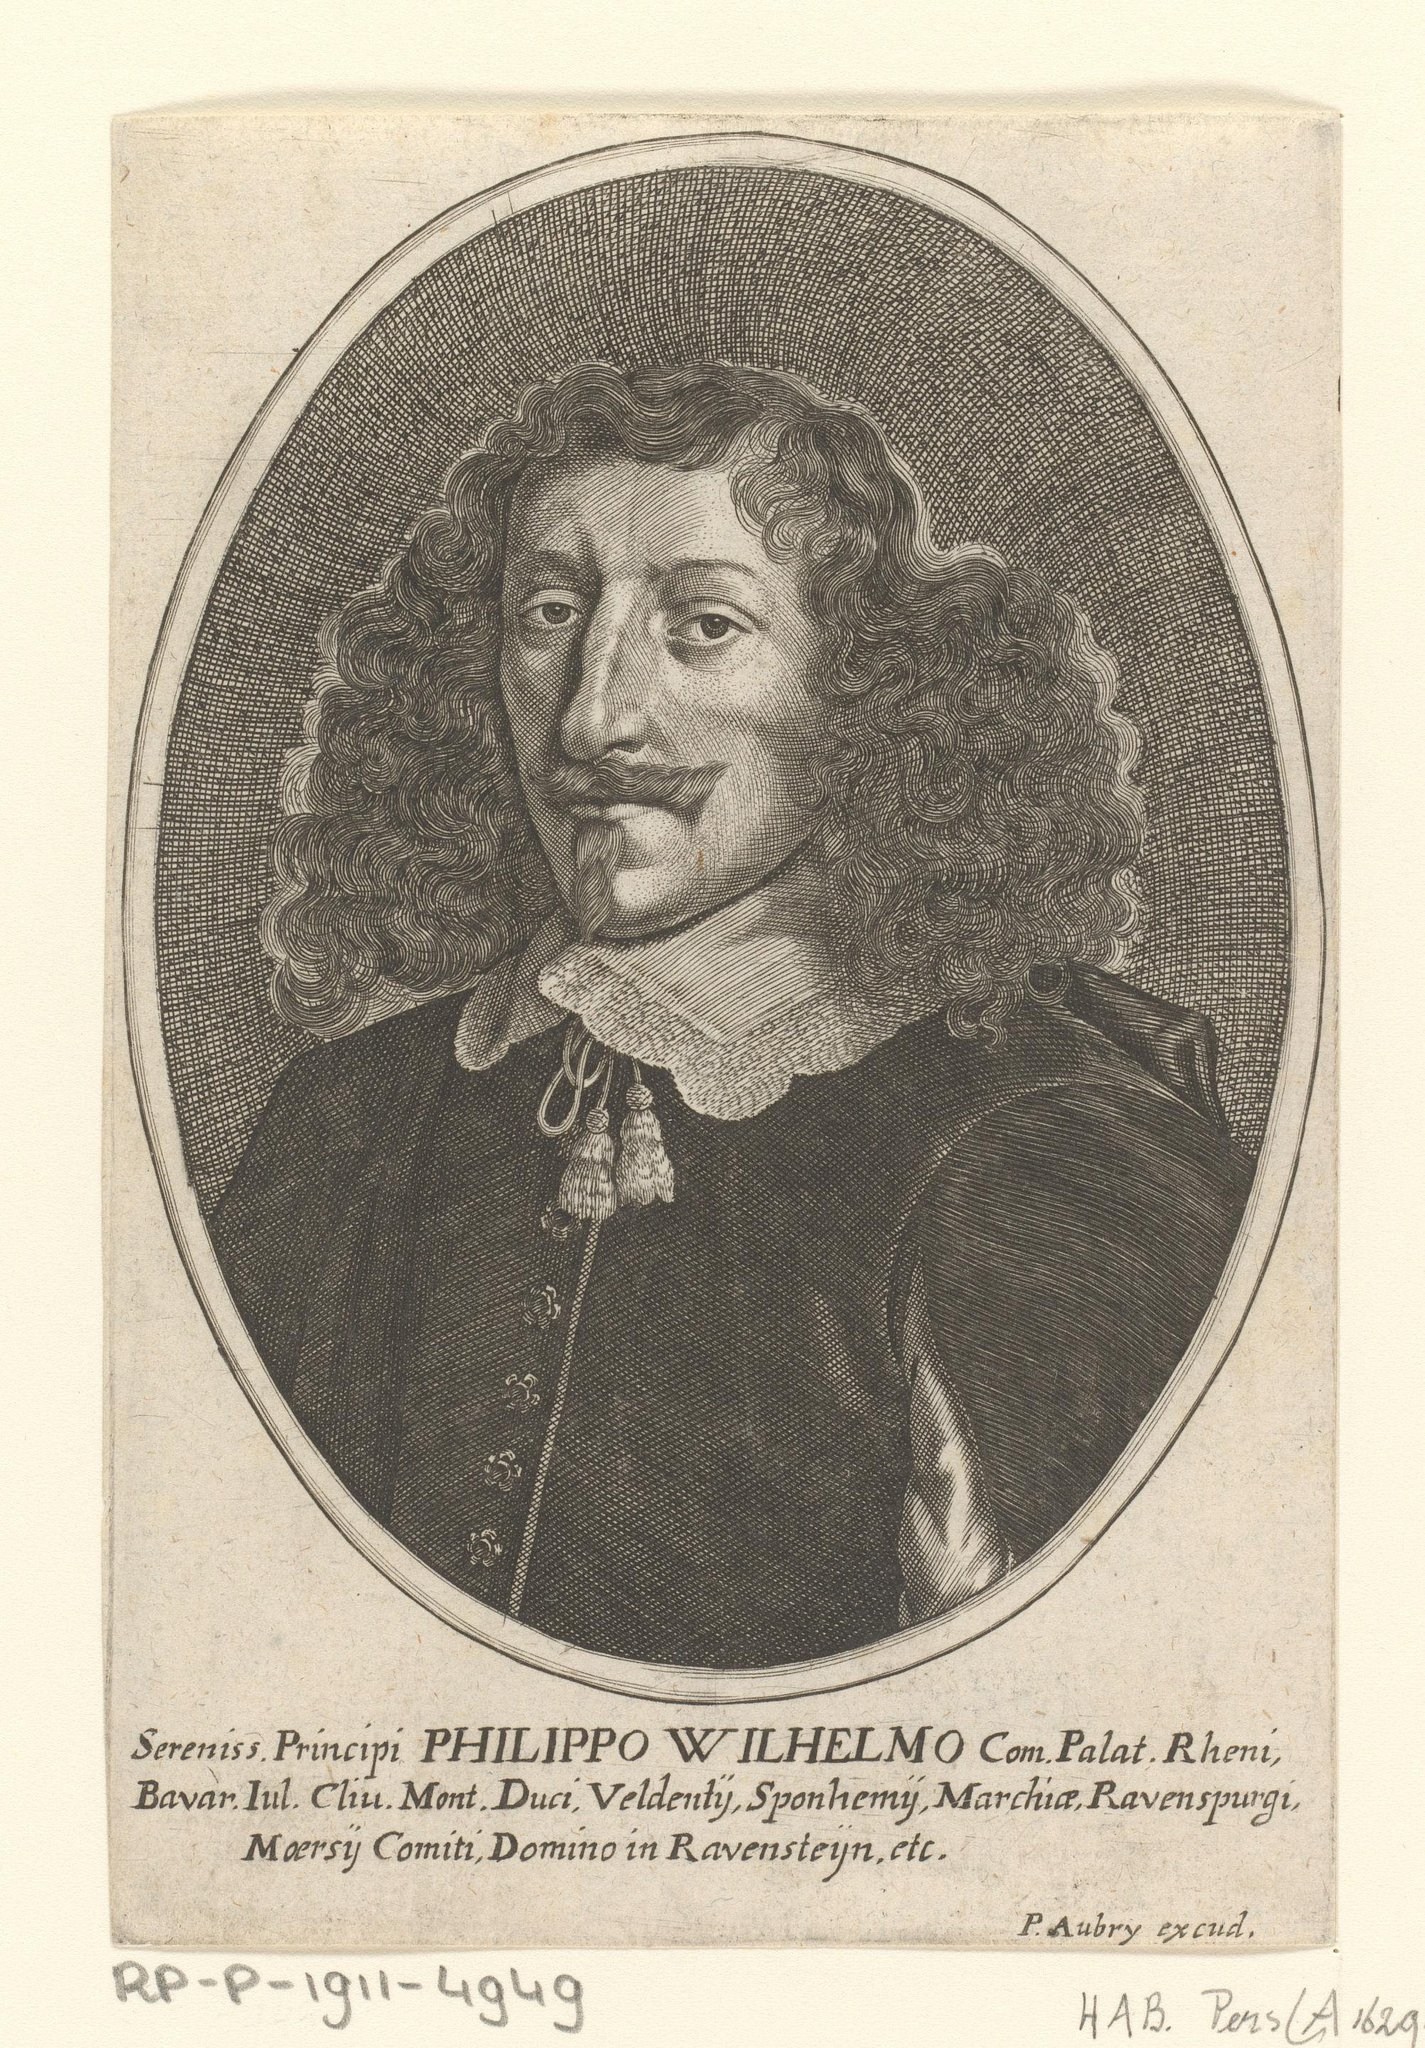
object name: print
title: Portret van Filips Willem van de Palts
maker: Anonymous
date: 1653-1686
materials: paper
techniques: engraving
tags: vienna, historical persons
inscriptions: collector's mark: Lugt 2228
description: Met drieregelig onderschrift in het Latijn.